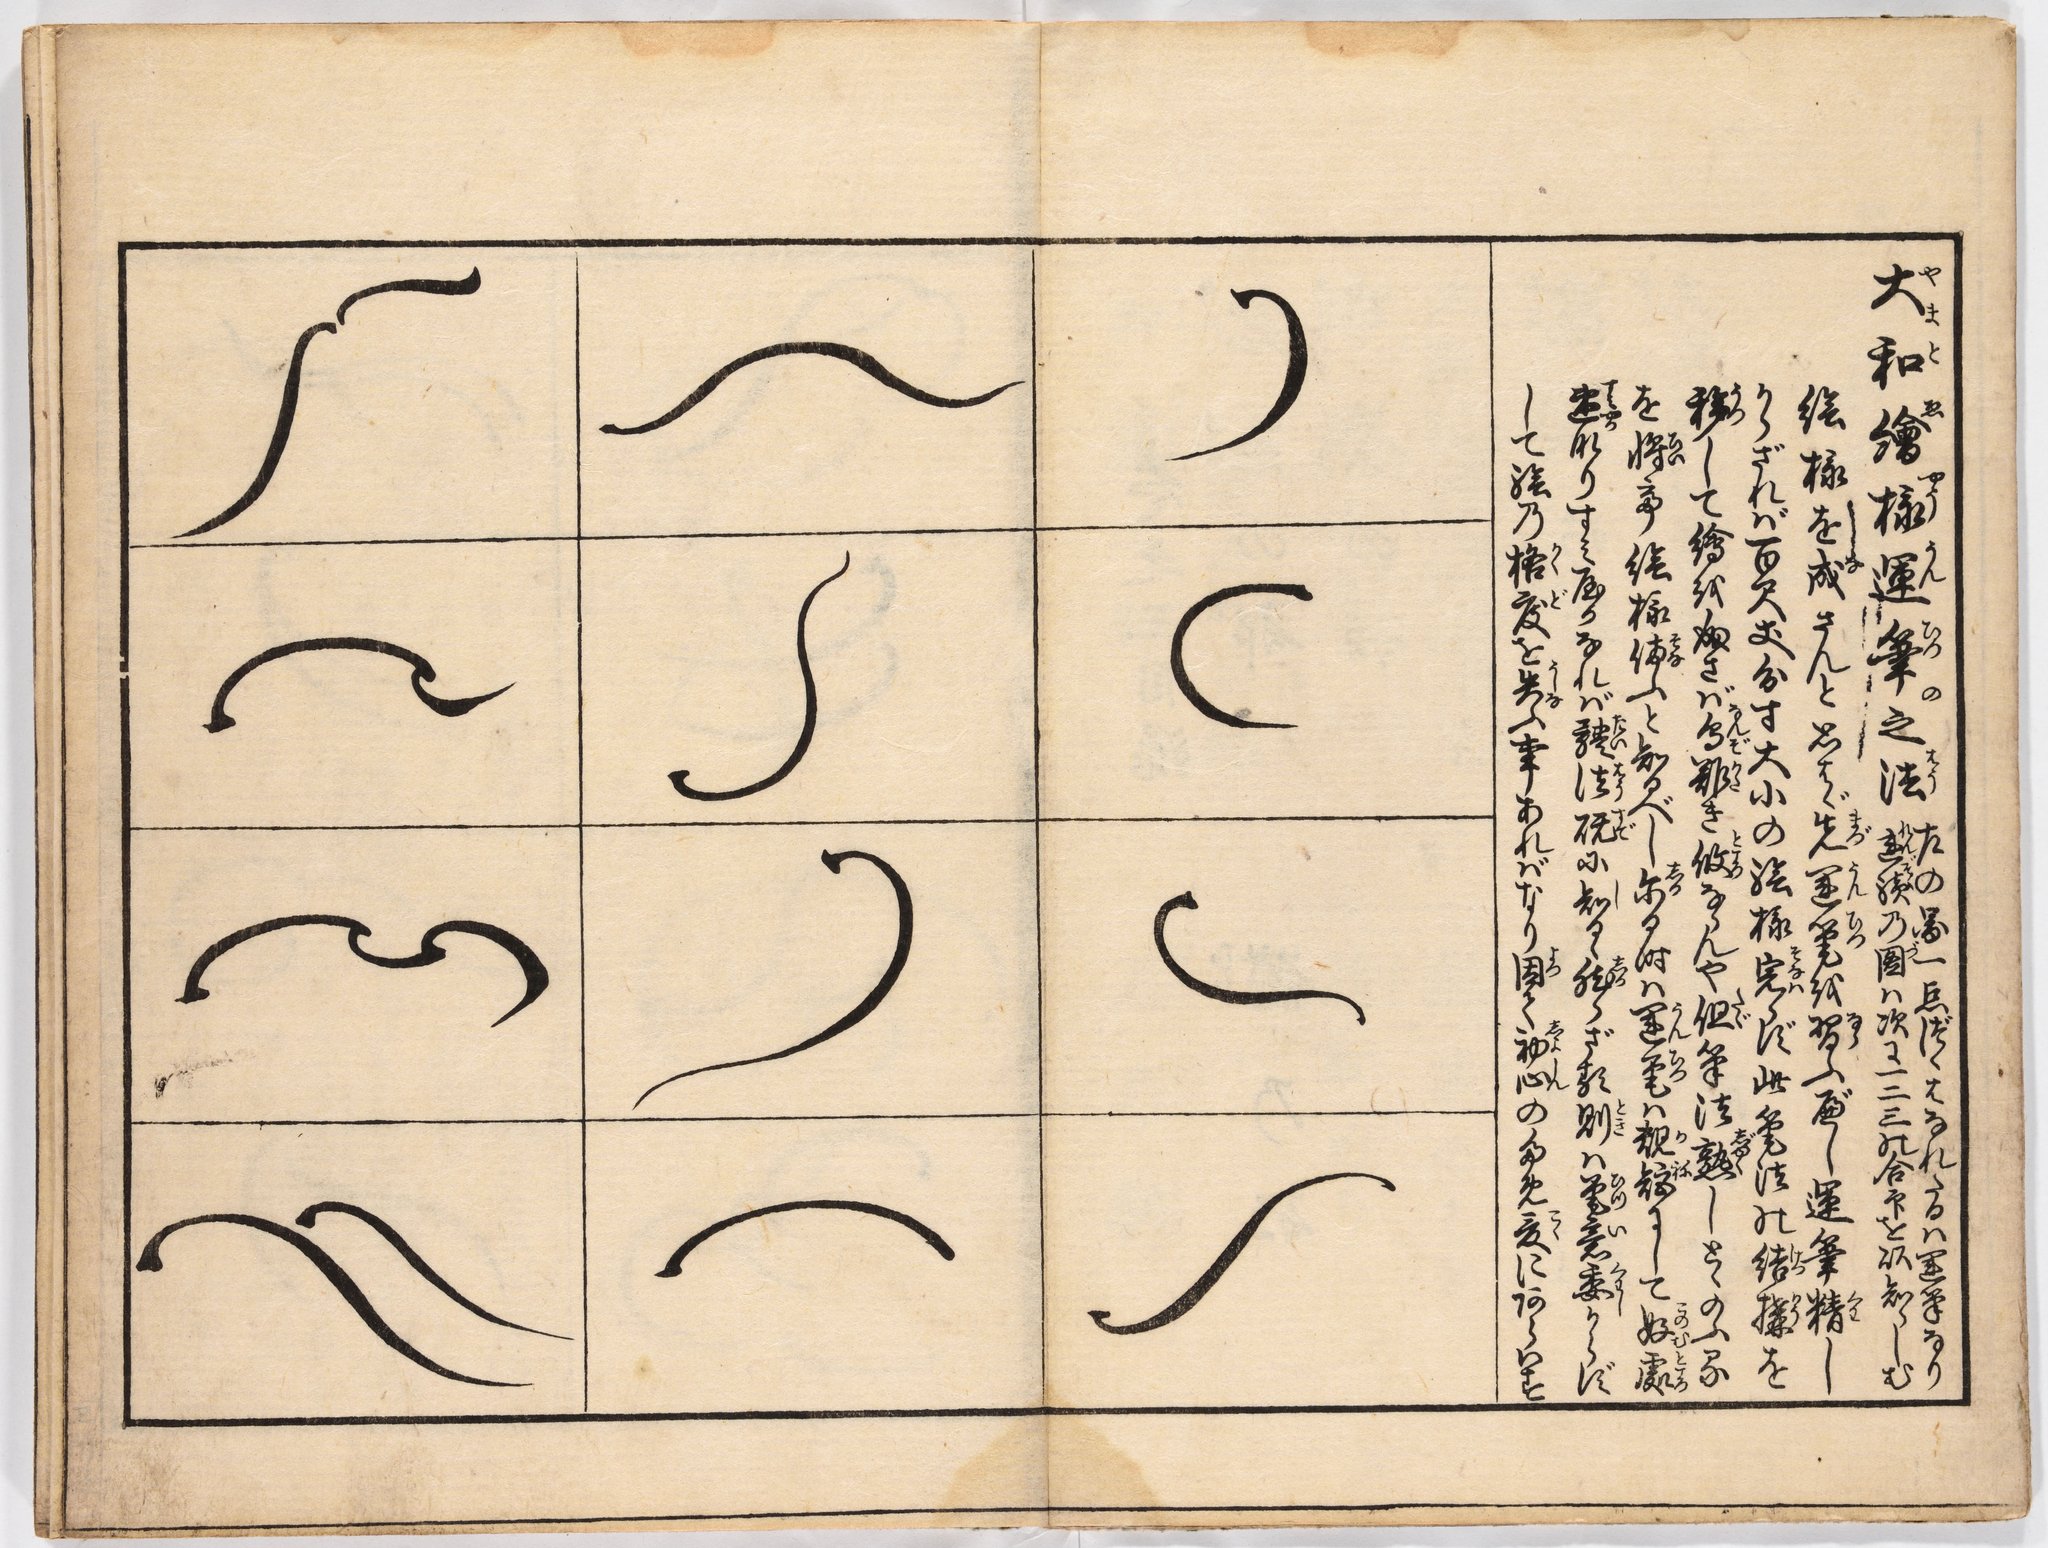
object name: illustrated book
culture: japanese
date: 1893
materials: ink, paper